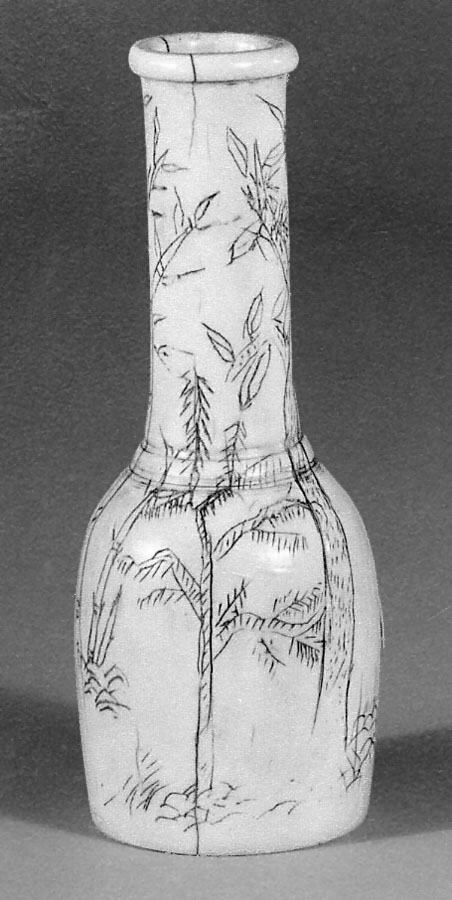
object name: bottle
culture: chinese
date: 1701-1800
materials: ivory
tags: trees